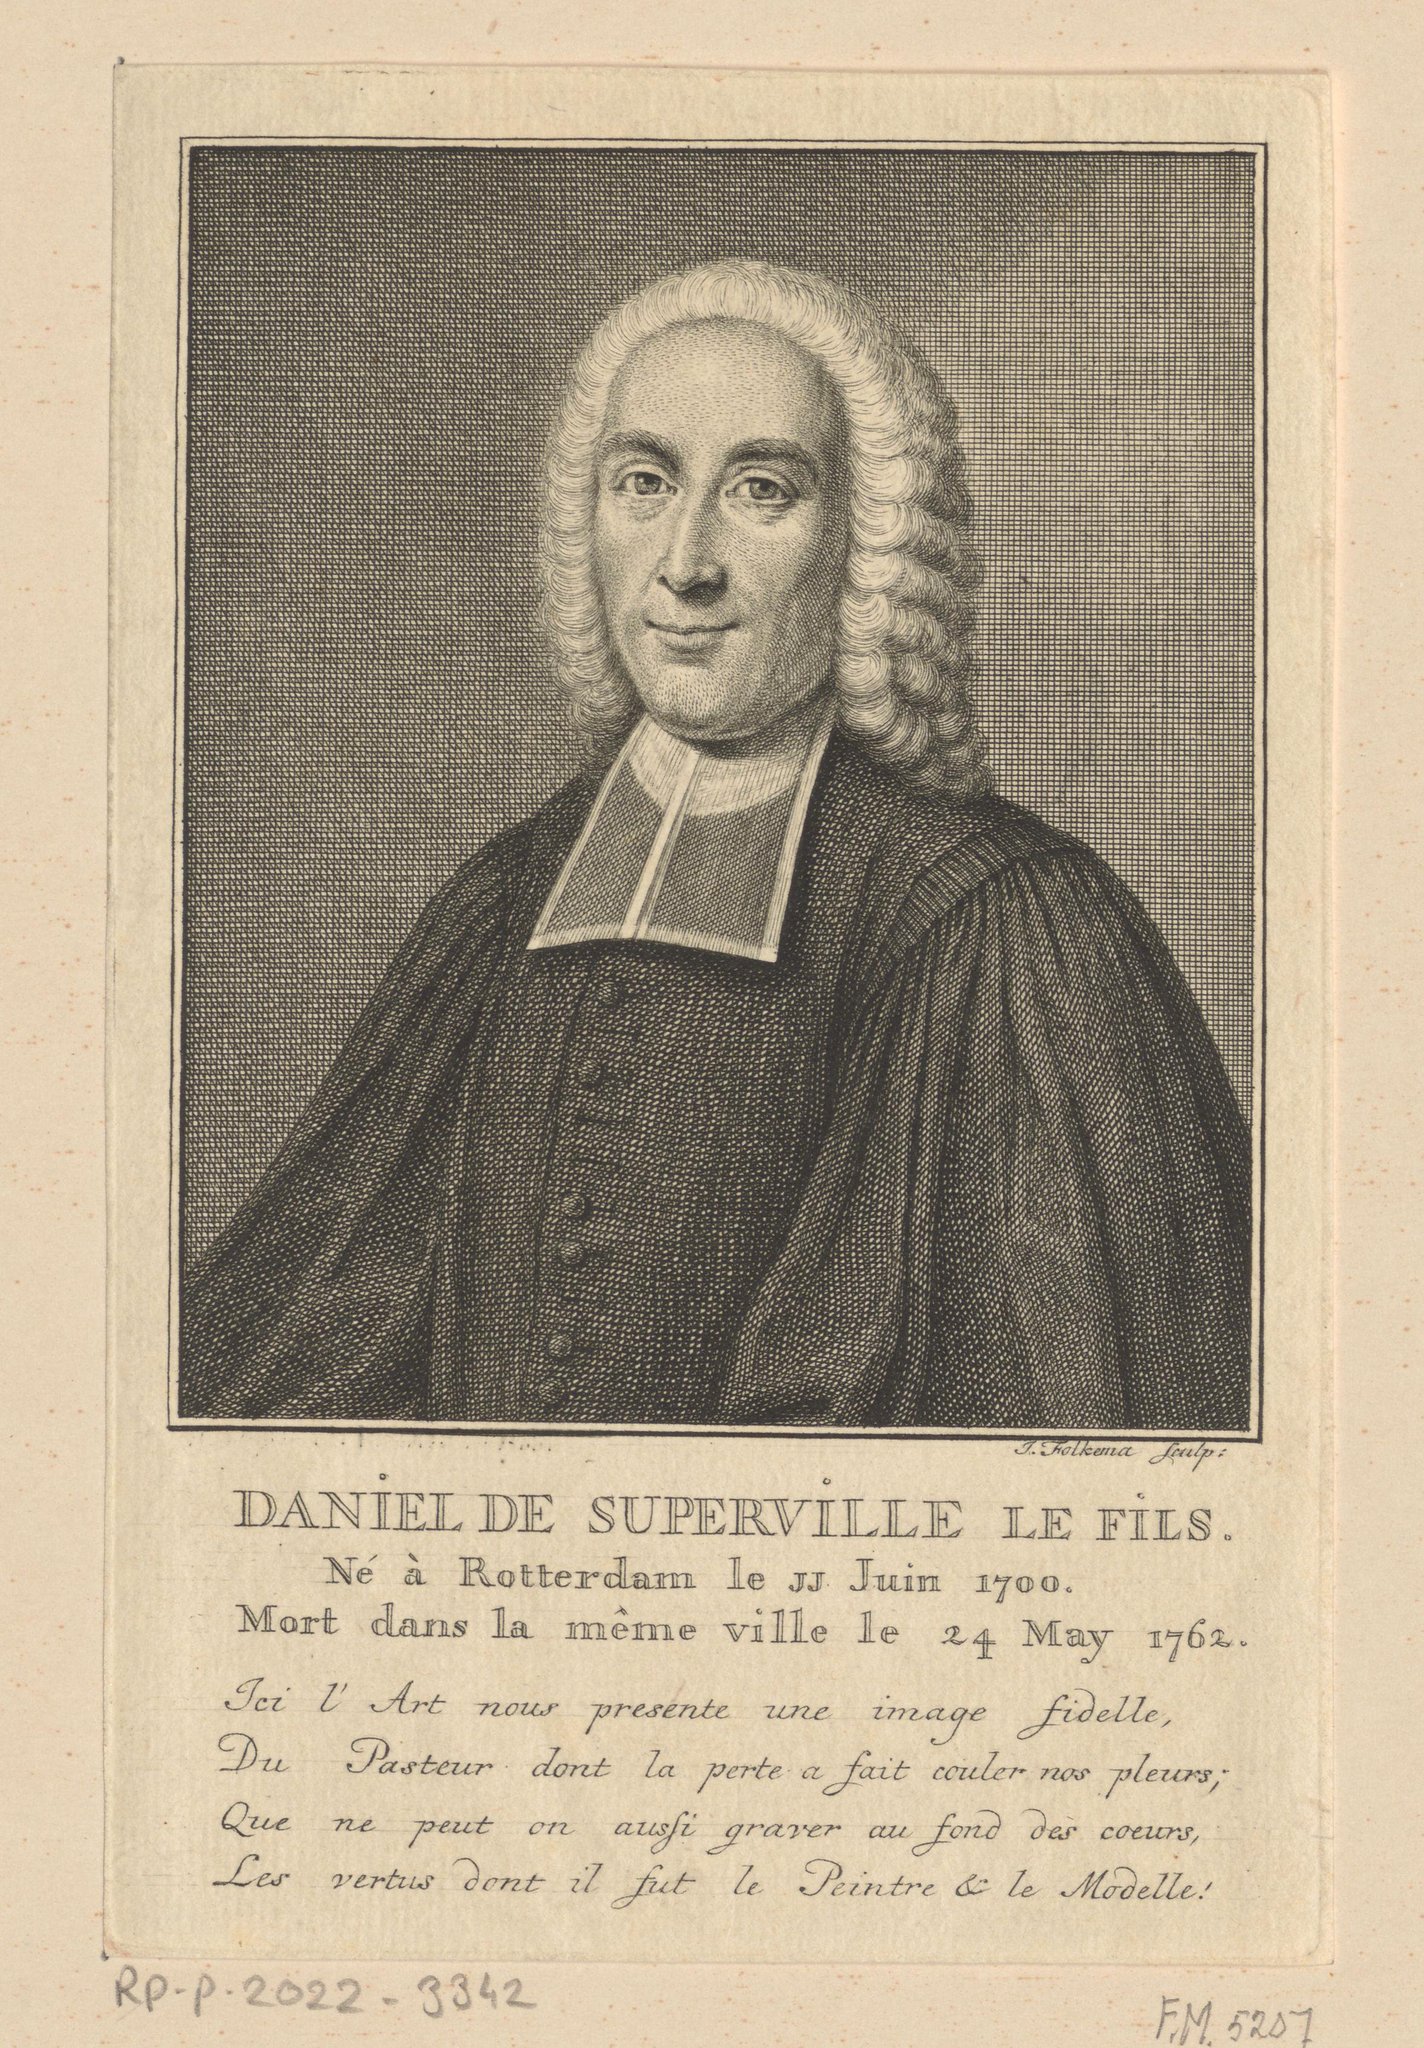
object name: print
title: Portret van Daniel de Superville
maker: jacob folkema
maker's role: draughtsman, print maker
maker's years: 1692-1767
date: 1760-1767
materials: paper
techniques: engraving, etching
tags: rotterdam, historical persons, physician, doctor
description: Onder het portret een vierregelig vers in het Frans.